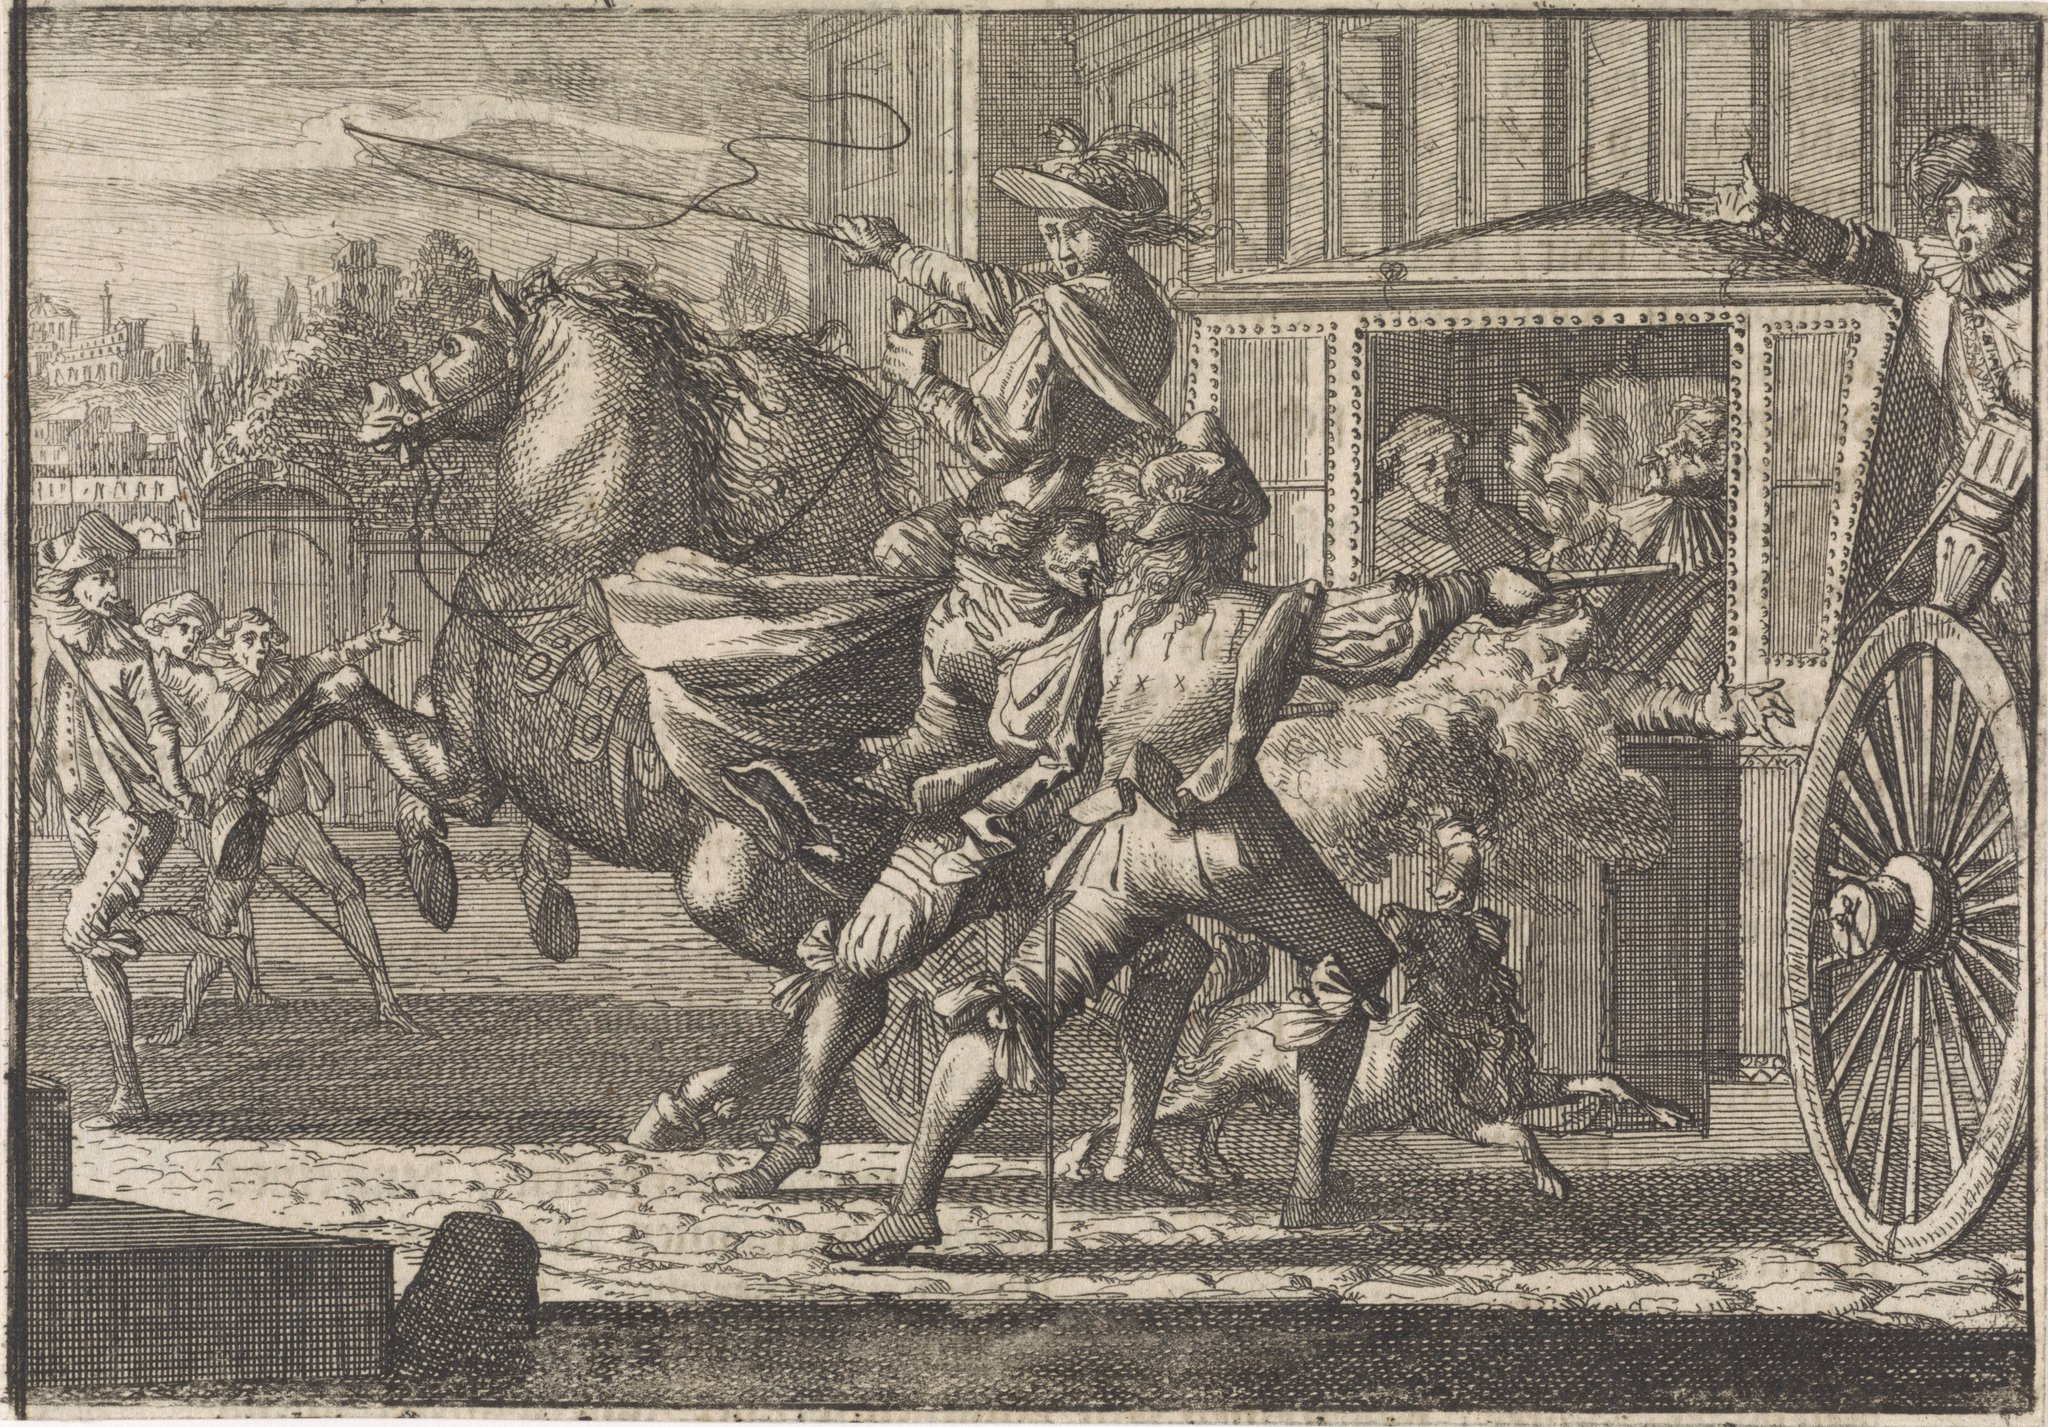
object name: print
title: Aanslag op Nicolau Monteiro, prior van Cedofeita, in de straten van Rome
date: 1701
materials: paper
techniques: etching, letterpress printing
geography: frankfurt am main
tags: murder, attempt, political murder, rome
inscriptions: collector's mark: Lugt 2228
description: Nicolau Monteiro, prior van Cedofeita, wordt in de straten van Rome aangevallen door zijn tegenstanders, die met pistolen zijn koets beschieten en een dienaar vermoorden.